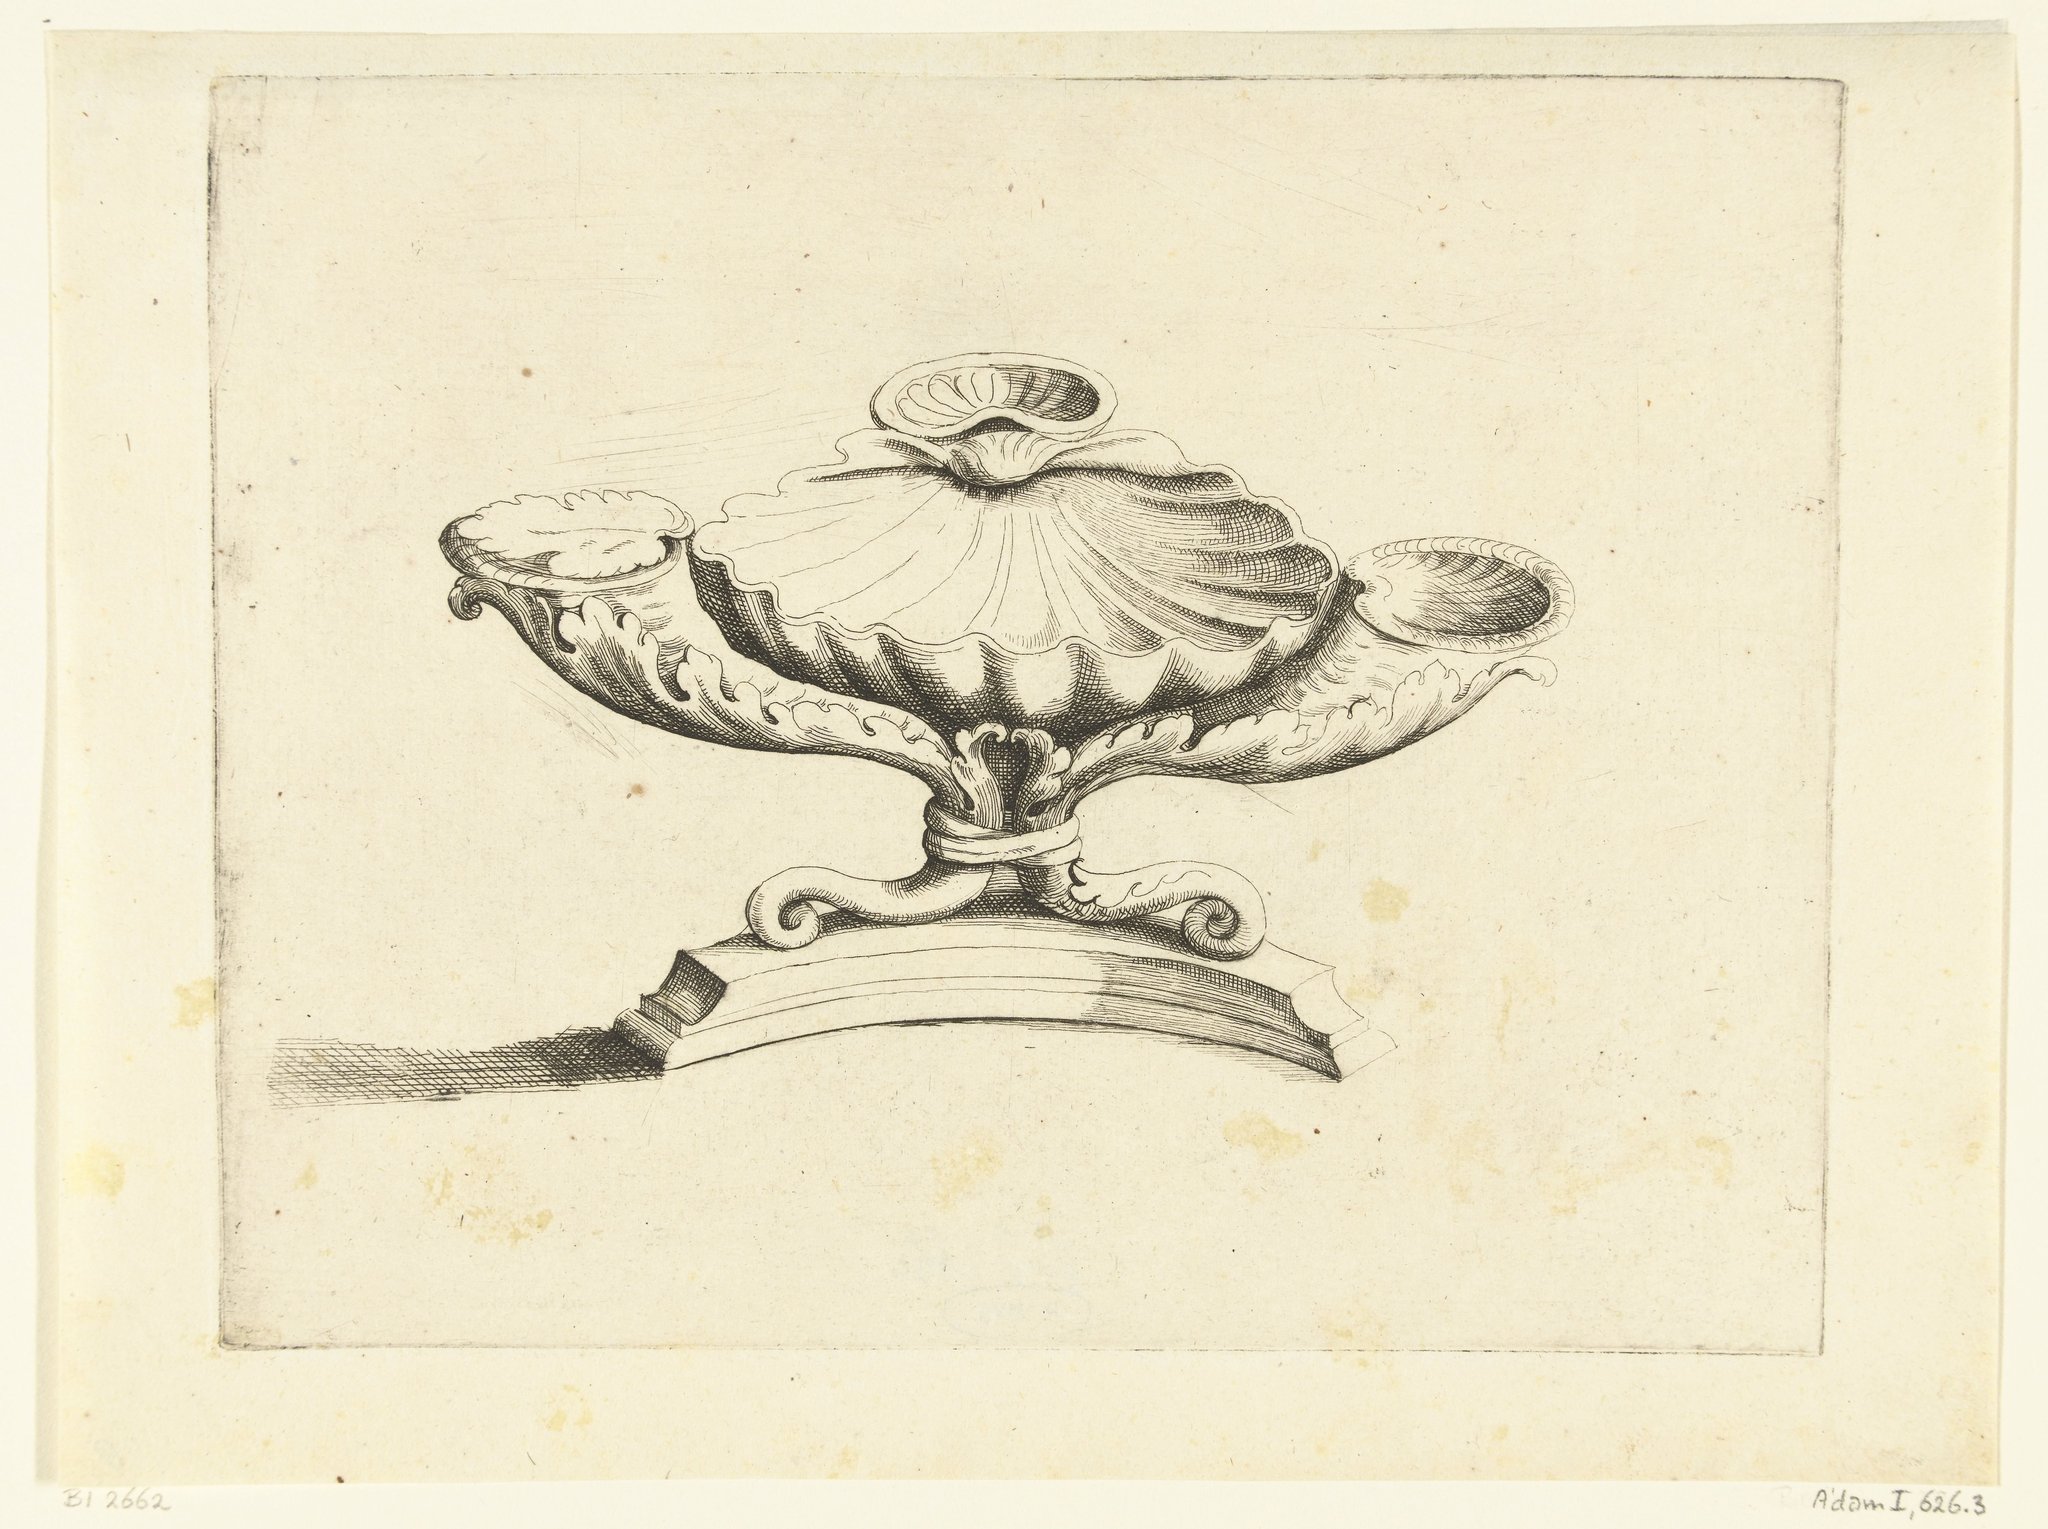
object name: print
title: Schaal in de vorm van een schelp, liggend in een houder bestaande uit drie horens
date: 1614-1654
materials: paper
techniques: etching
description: De horens hebben schelpvormige uiteinden. Uit serie van 14 bladen met schalen, kommen en kistjes.